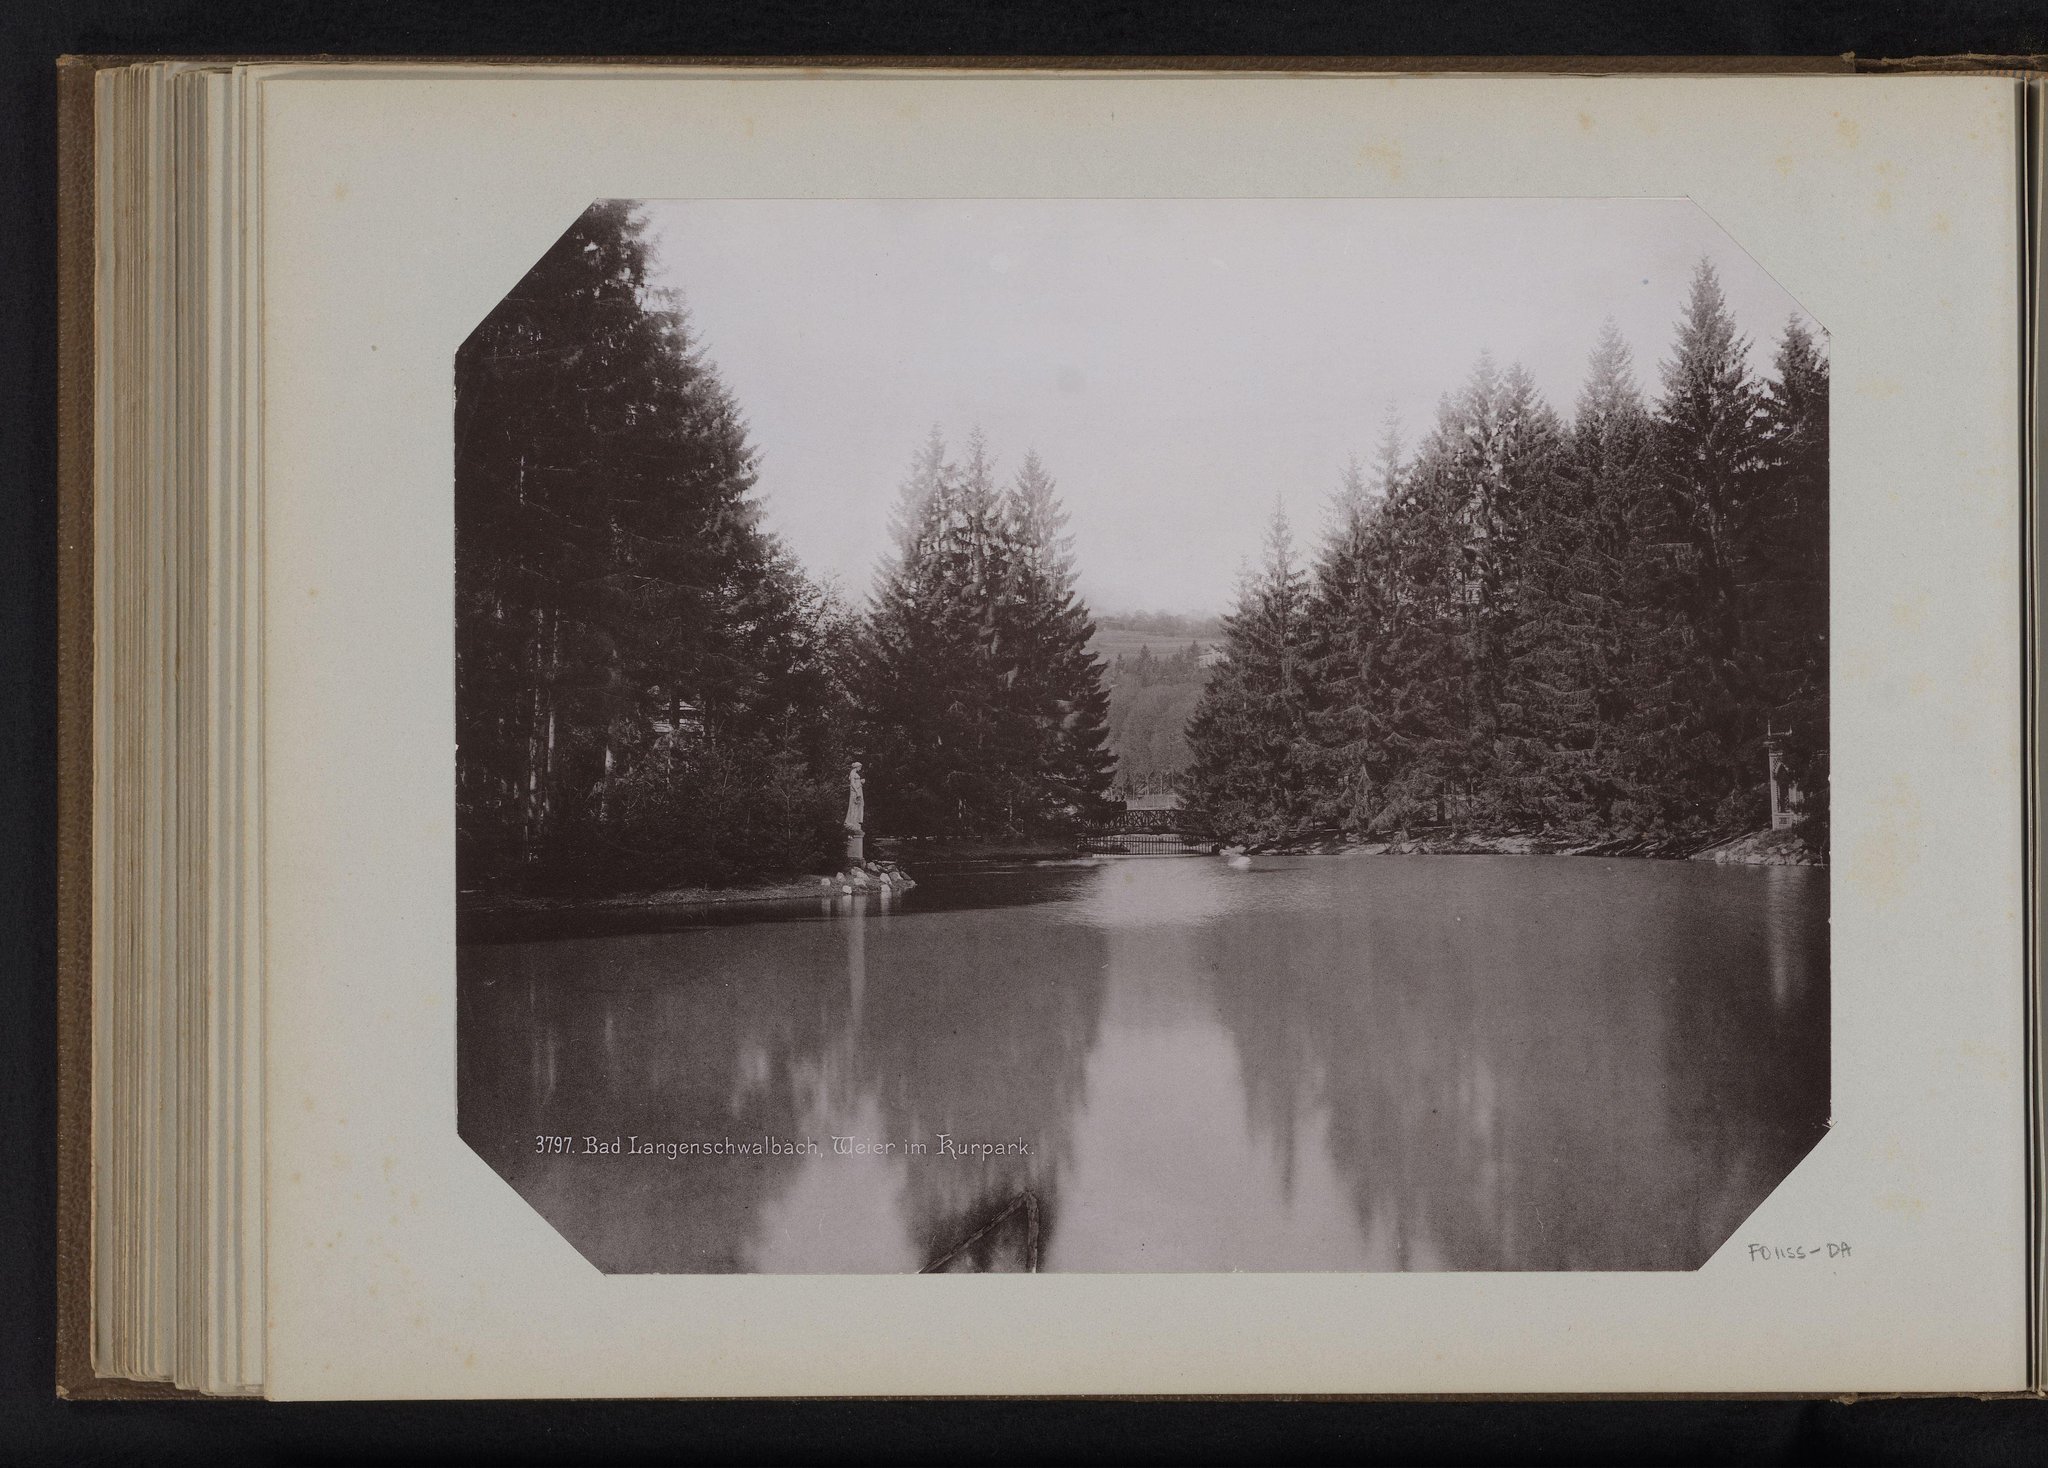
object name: photomechanical print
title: Gezicht op het Kurpark te Bad Schwalbach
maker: Anonymous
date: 1890-1899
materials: paper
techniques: photograph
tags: public gardens, park (+ city(-scape) with figures, staffage)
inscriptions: inscription: ‘3779. Bad Langenschwalbach, Weier im Kurpark’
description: Deze prent maakt deel uit van een album.